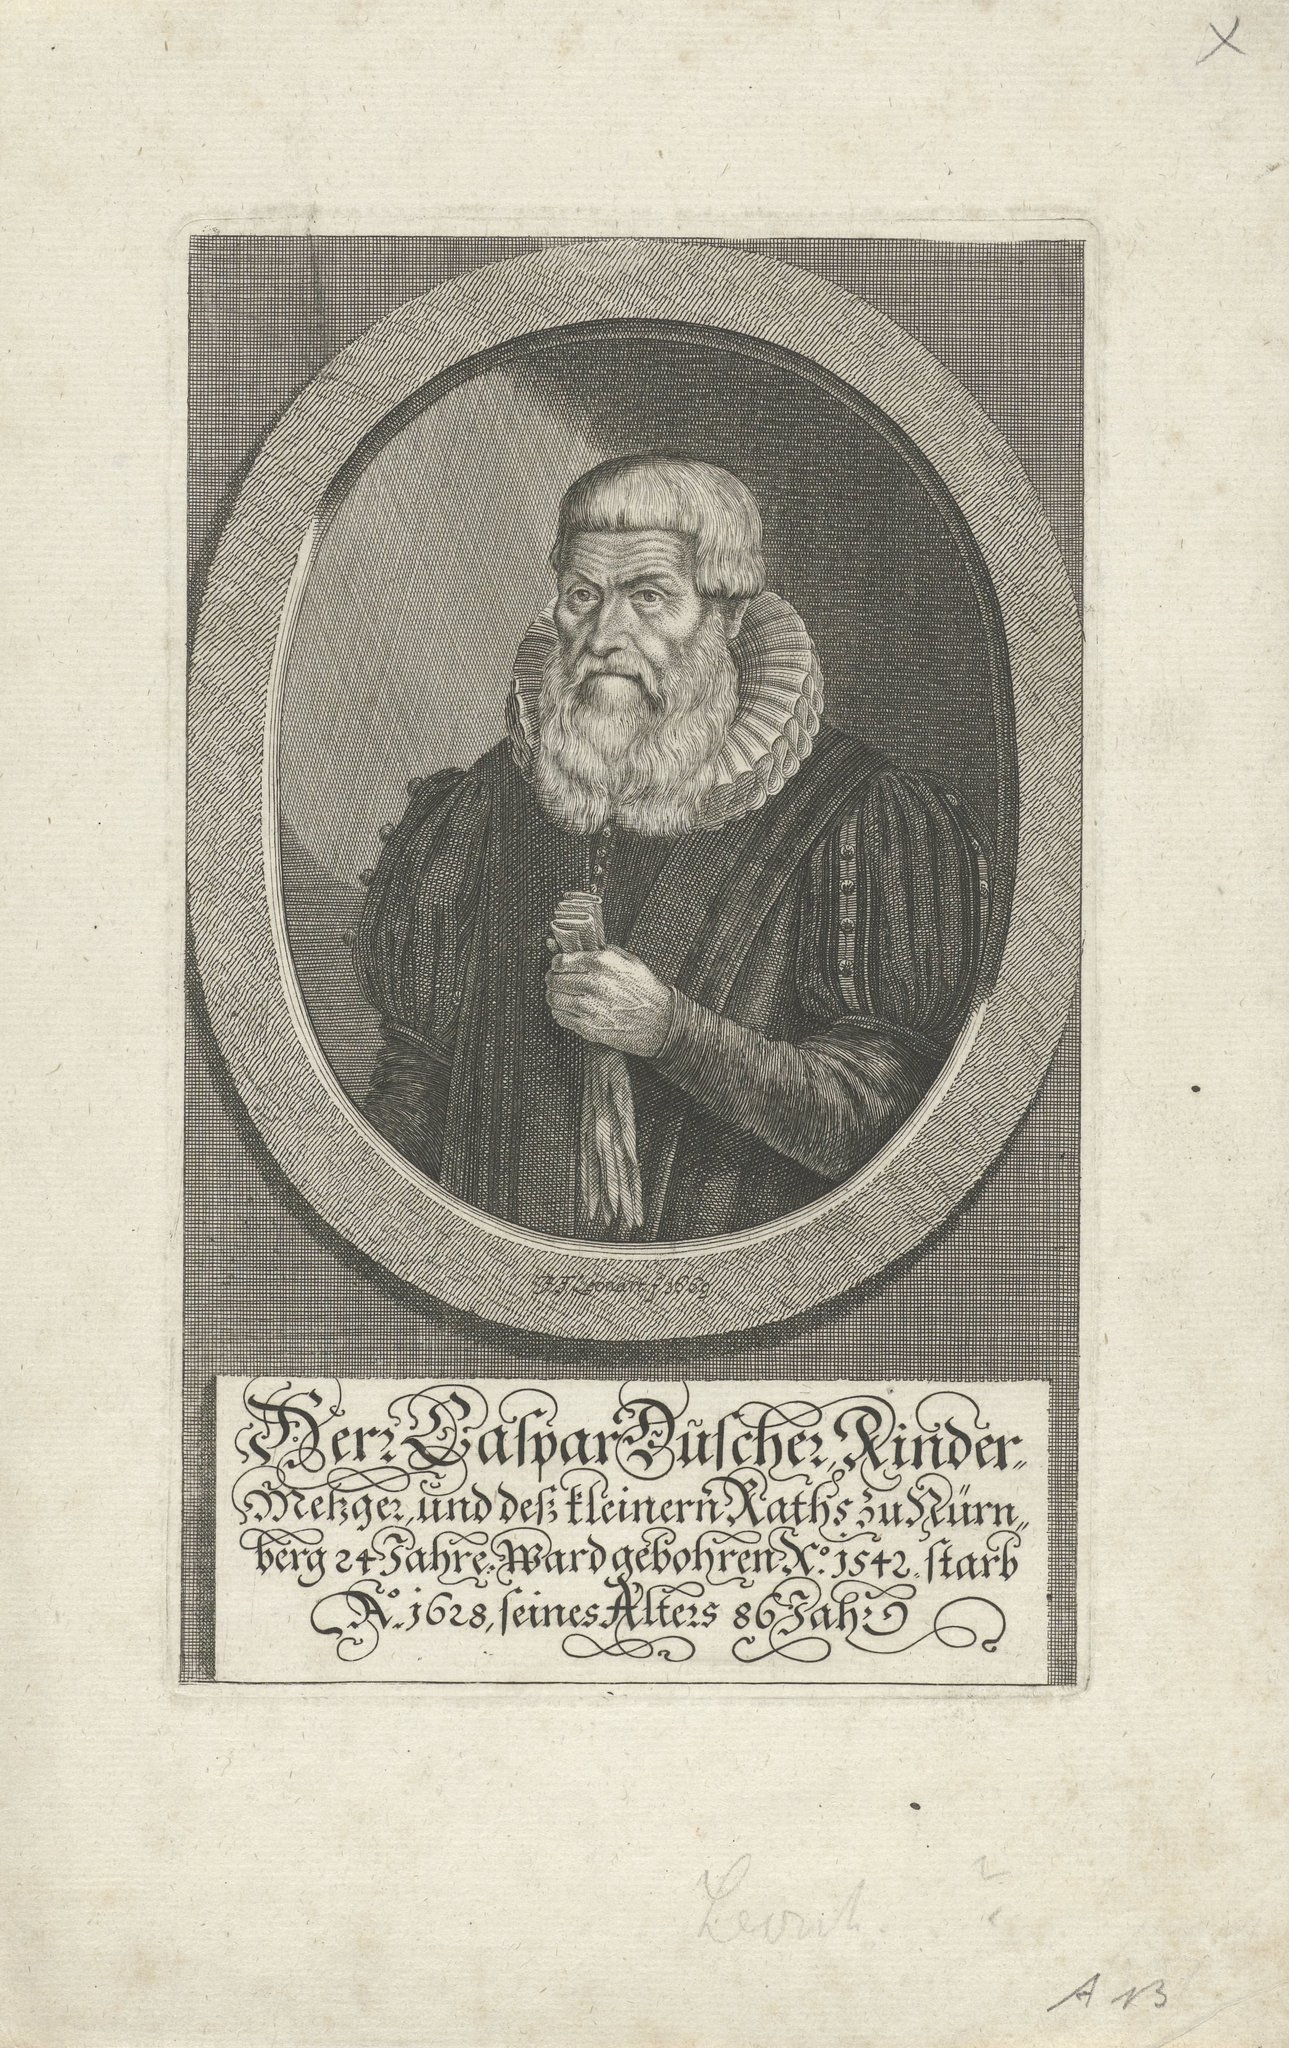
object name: print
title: Portret van Caspar Duscher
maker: johann friedrich leonard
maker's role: print maker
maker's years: 1633-1680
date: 1669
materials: paper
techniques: engraving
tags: raadslid, slager, caspar duscher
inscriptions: collector's mark: Lugt 2228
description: Portret van Caspar Duscher, slager en lid van de Kleine Raad te Neurenberg.